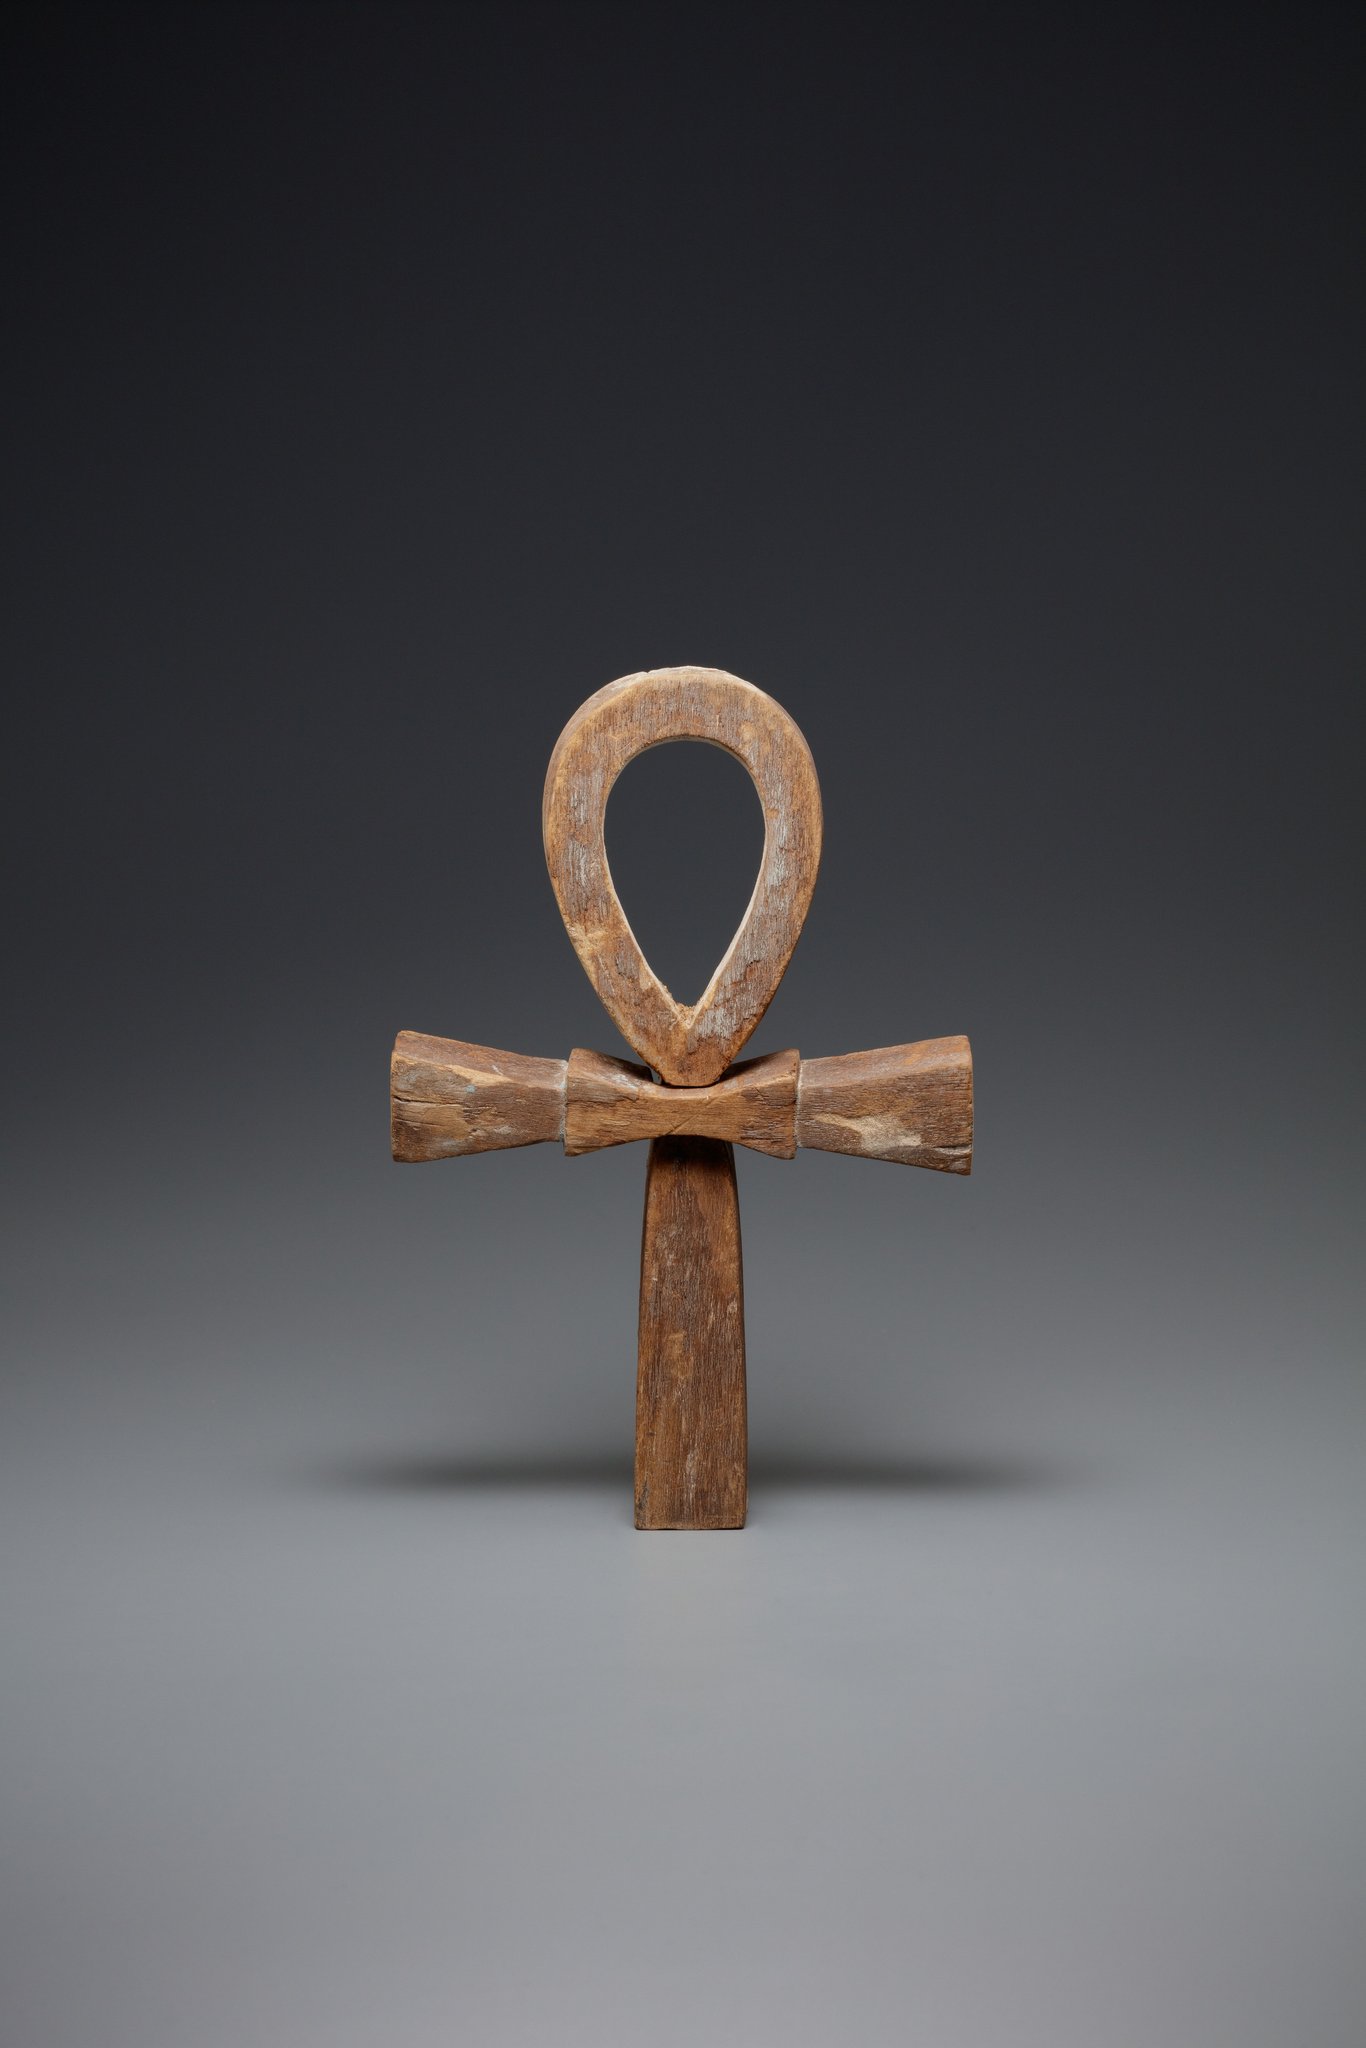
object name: model, ankh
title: Model ankh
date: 1981-1802 BCE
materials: wood